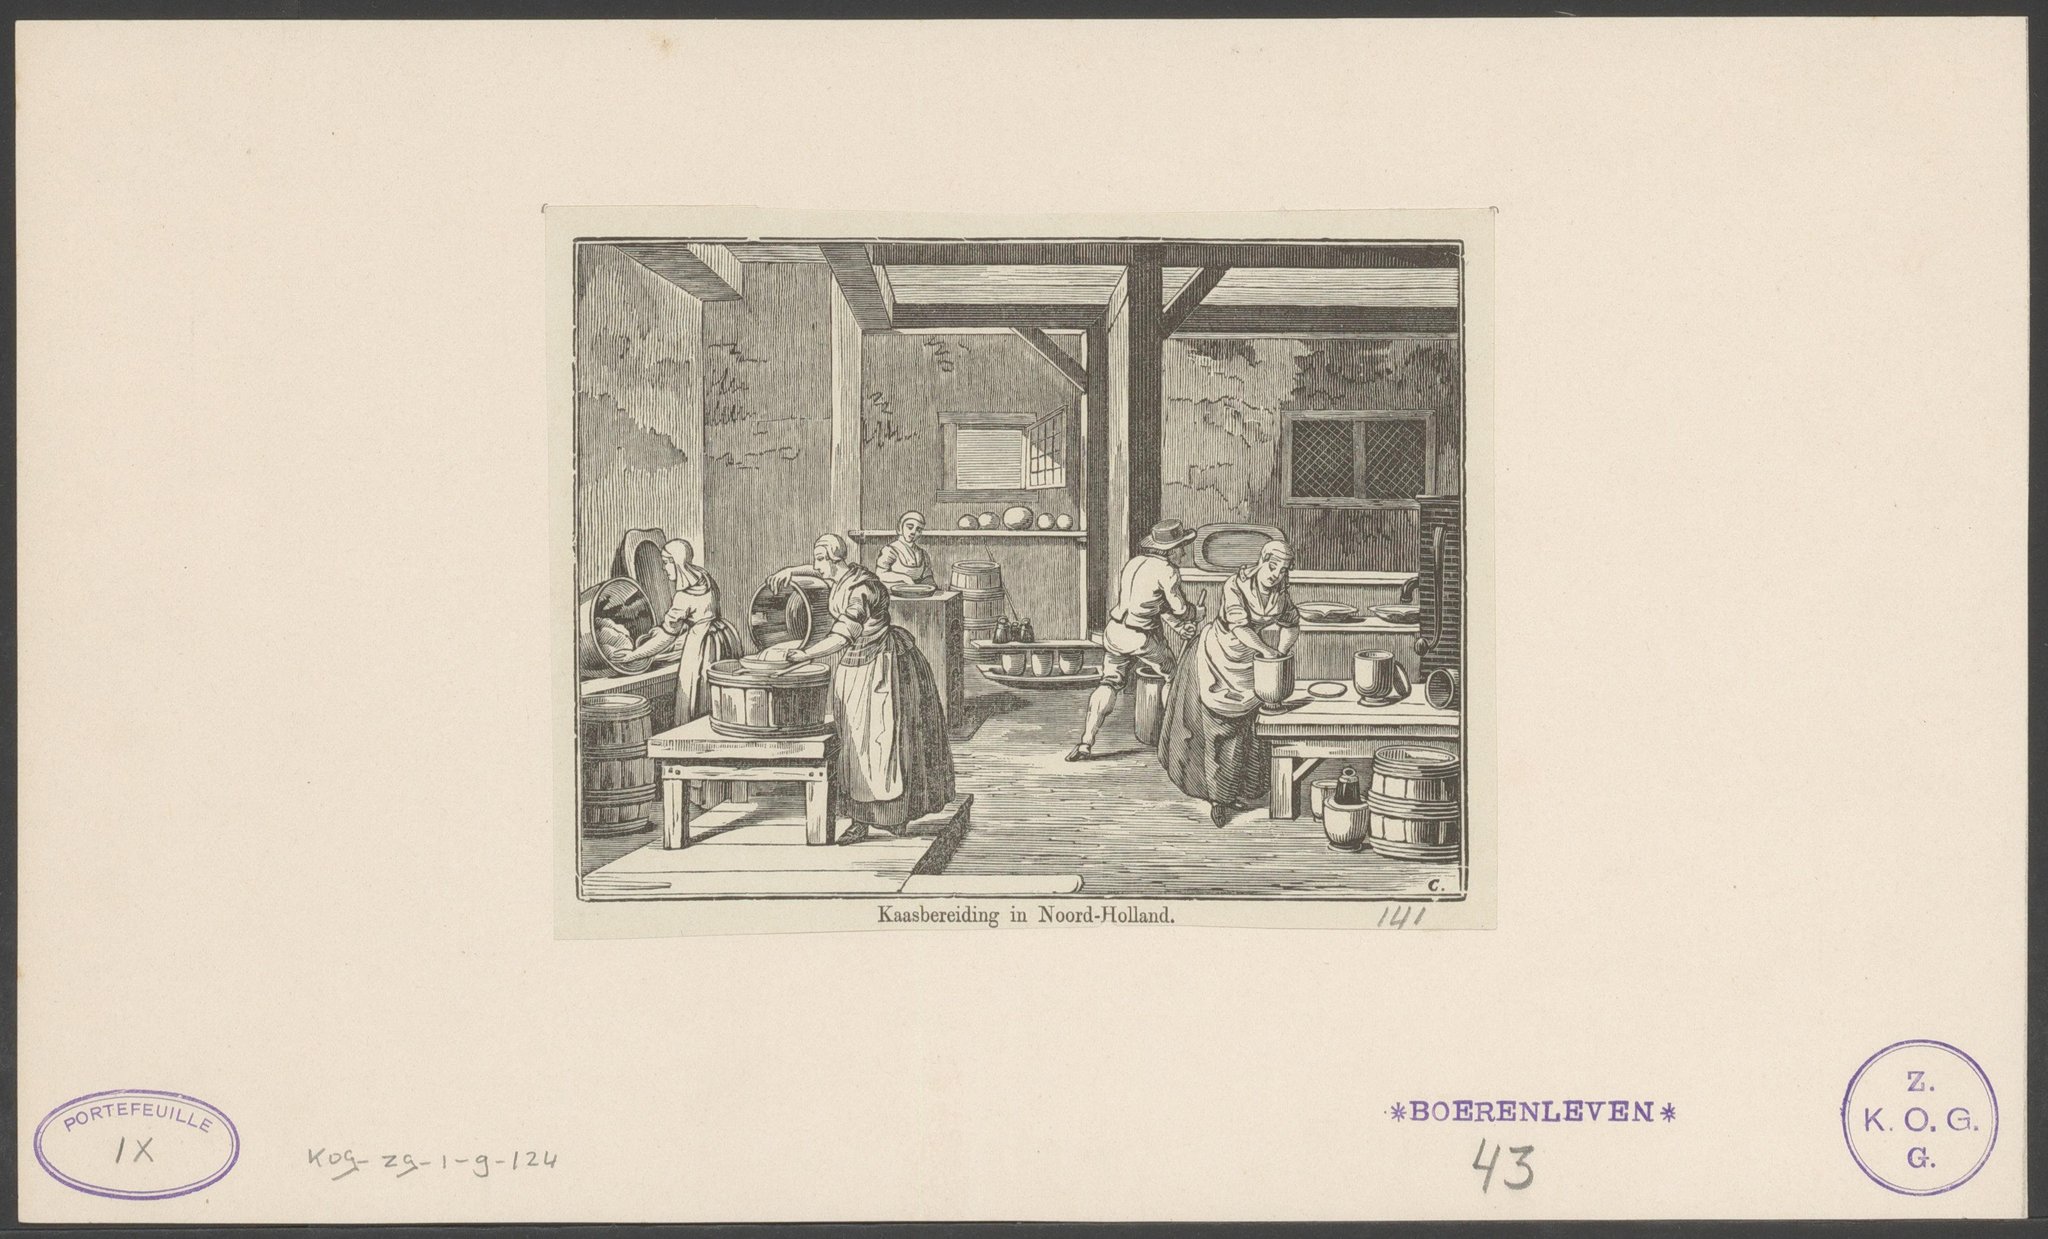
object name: print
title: Kaas maken in Noord-Holland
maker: Anonymous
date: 1861-1869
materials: paper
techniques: engraving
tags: dairy products, cheese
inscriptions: collector's mark: Lugt 1641, signature: ‘C.’, stamp, stamp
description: Prent mogelijk uit: Brill, Hendrik Johannes. Karel en Willem op reis door Nederland: de noordelijke provinciën. Tiel: weduwe D.R. van Wermeskerken, 1861. Of uit: Nederlandsch museum: geschied- en letterkundige merkwaardigheden, natuurbeschrijvingen, aardrijkskundige bijzonderheden, historische en romantische verhalen. Amsterdam: J.H. Laarman, 1869.